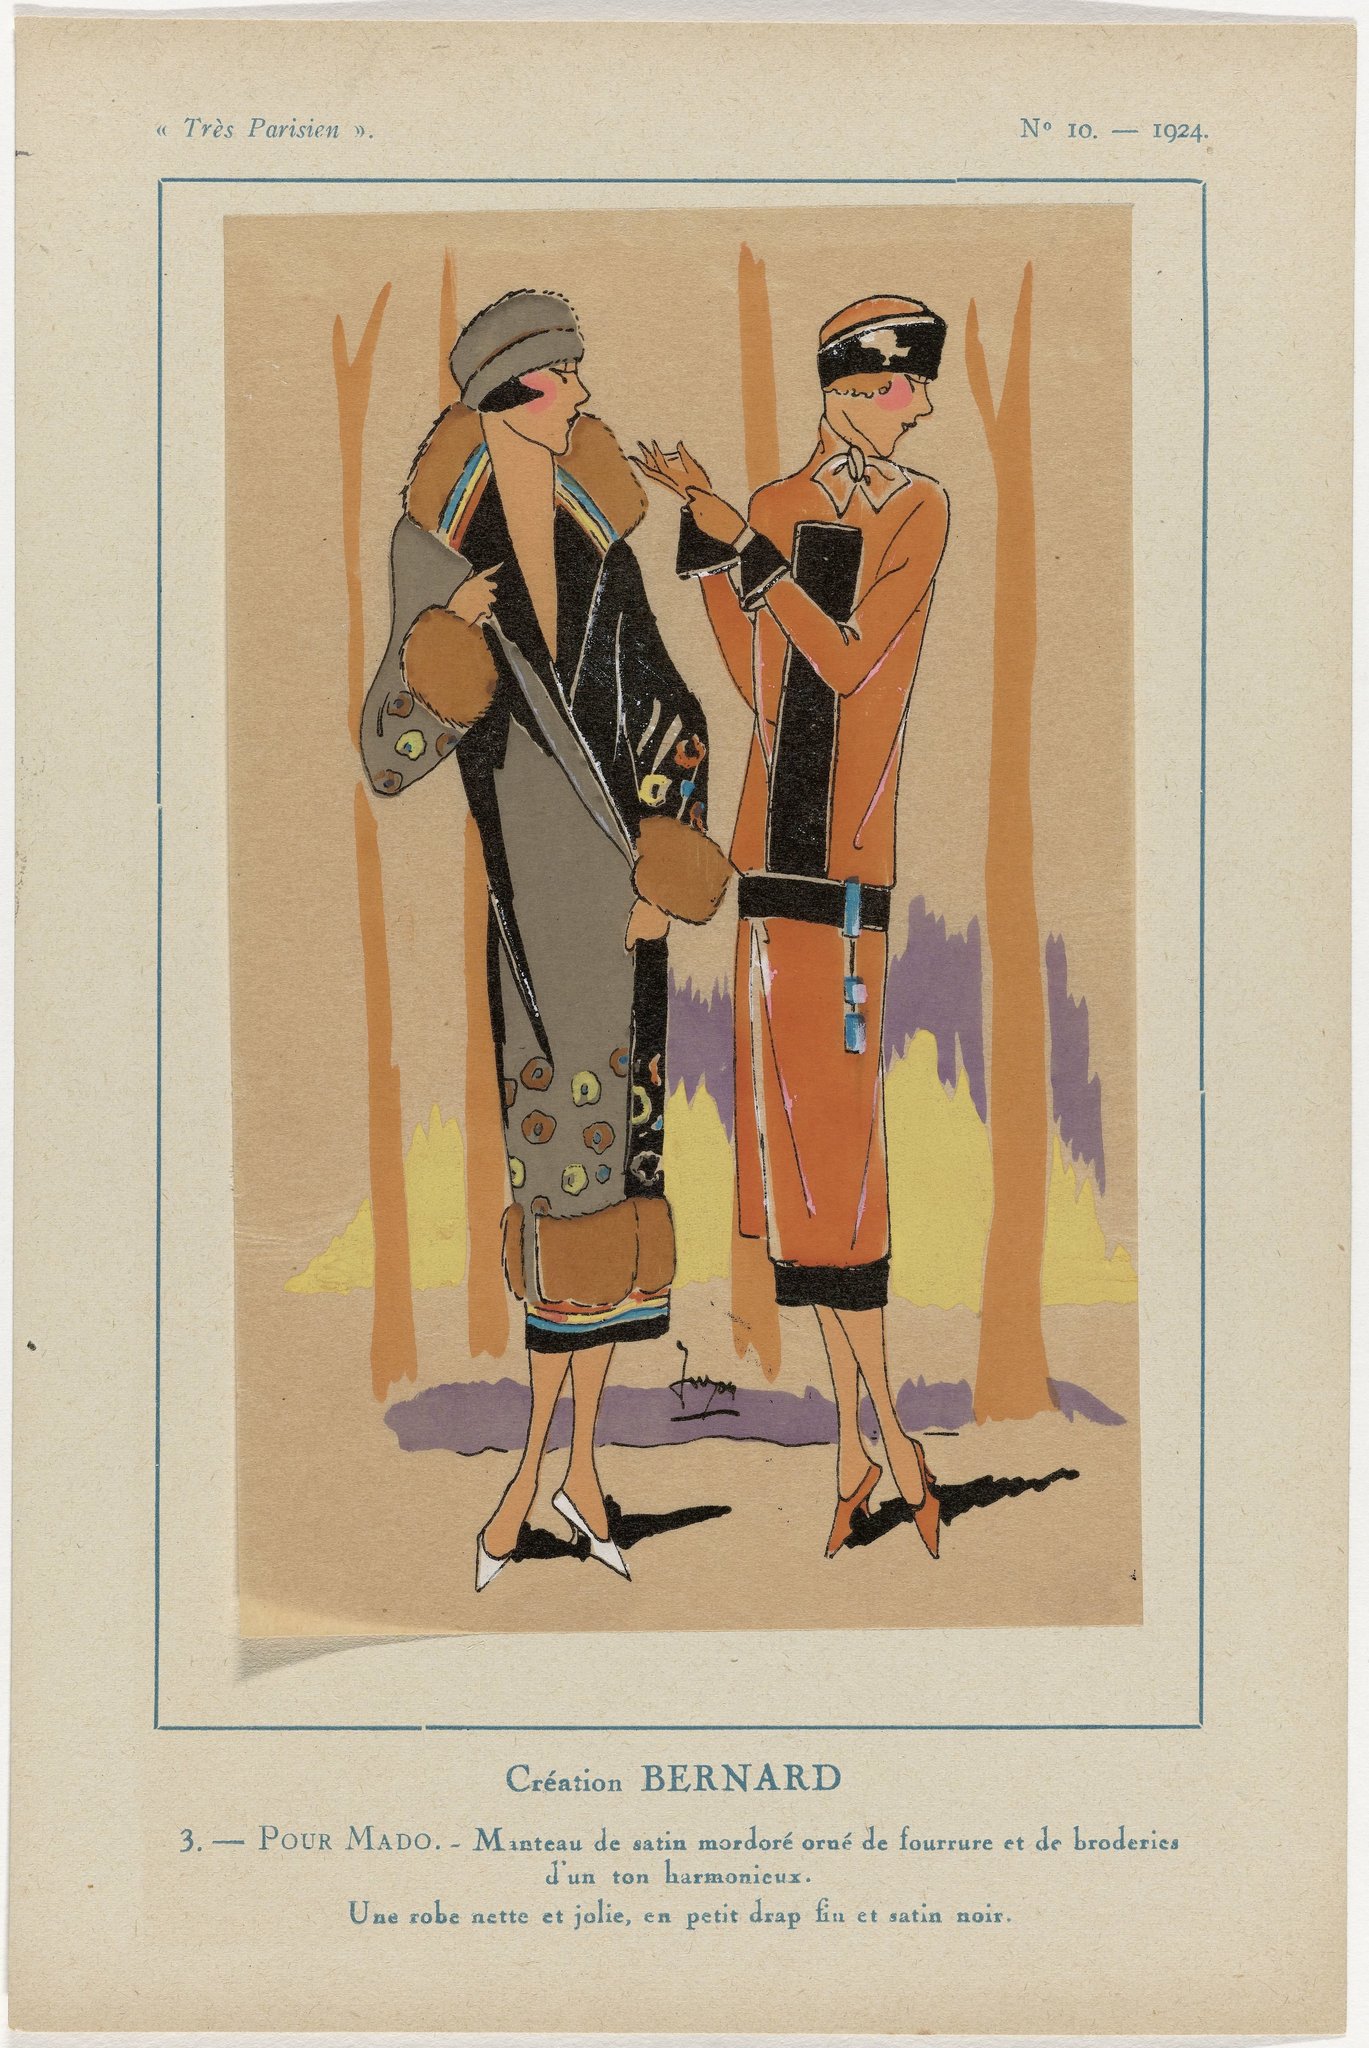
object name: fashion print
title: Très Parisien, 1924, No. 10 : Création BERNARD / 3.-Pour Mad (...)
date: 1924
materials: paper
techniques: hand coloring, letterpress printing, lithography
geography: paris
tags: embroidery (ornamentation) (+ women's clothes), coat (+ women's clothes), fashion plates, head-gear: hat (+ women's clothes), dress, gown (+ women's clothes), neck-gear: collar (+ fur used for clothes)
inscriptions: caption: ‘Création BERNARD / 3. - POUR MADO. - Manteau de satin mordoré orné de fourrure et de broderies d'un ton harmonieux. Une robe nette et jolie, en petit drap fin et satin noir.’, title: ‘" Très Parisien" / No 10. - 1924’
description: Ontwerp van Bernard. Mantel van bronskleurig satijn versierd met bont en borduurwerk. Jurk van 'petit drap fin' en zwart satijn. Prent uit het modetijdschrift Très Parisien (1920-1936).